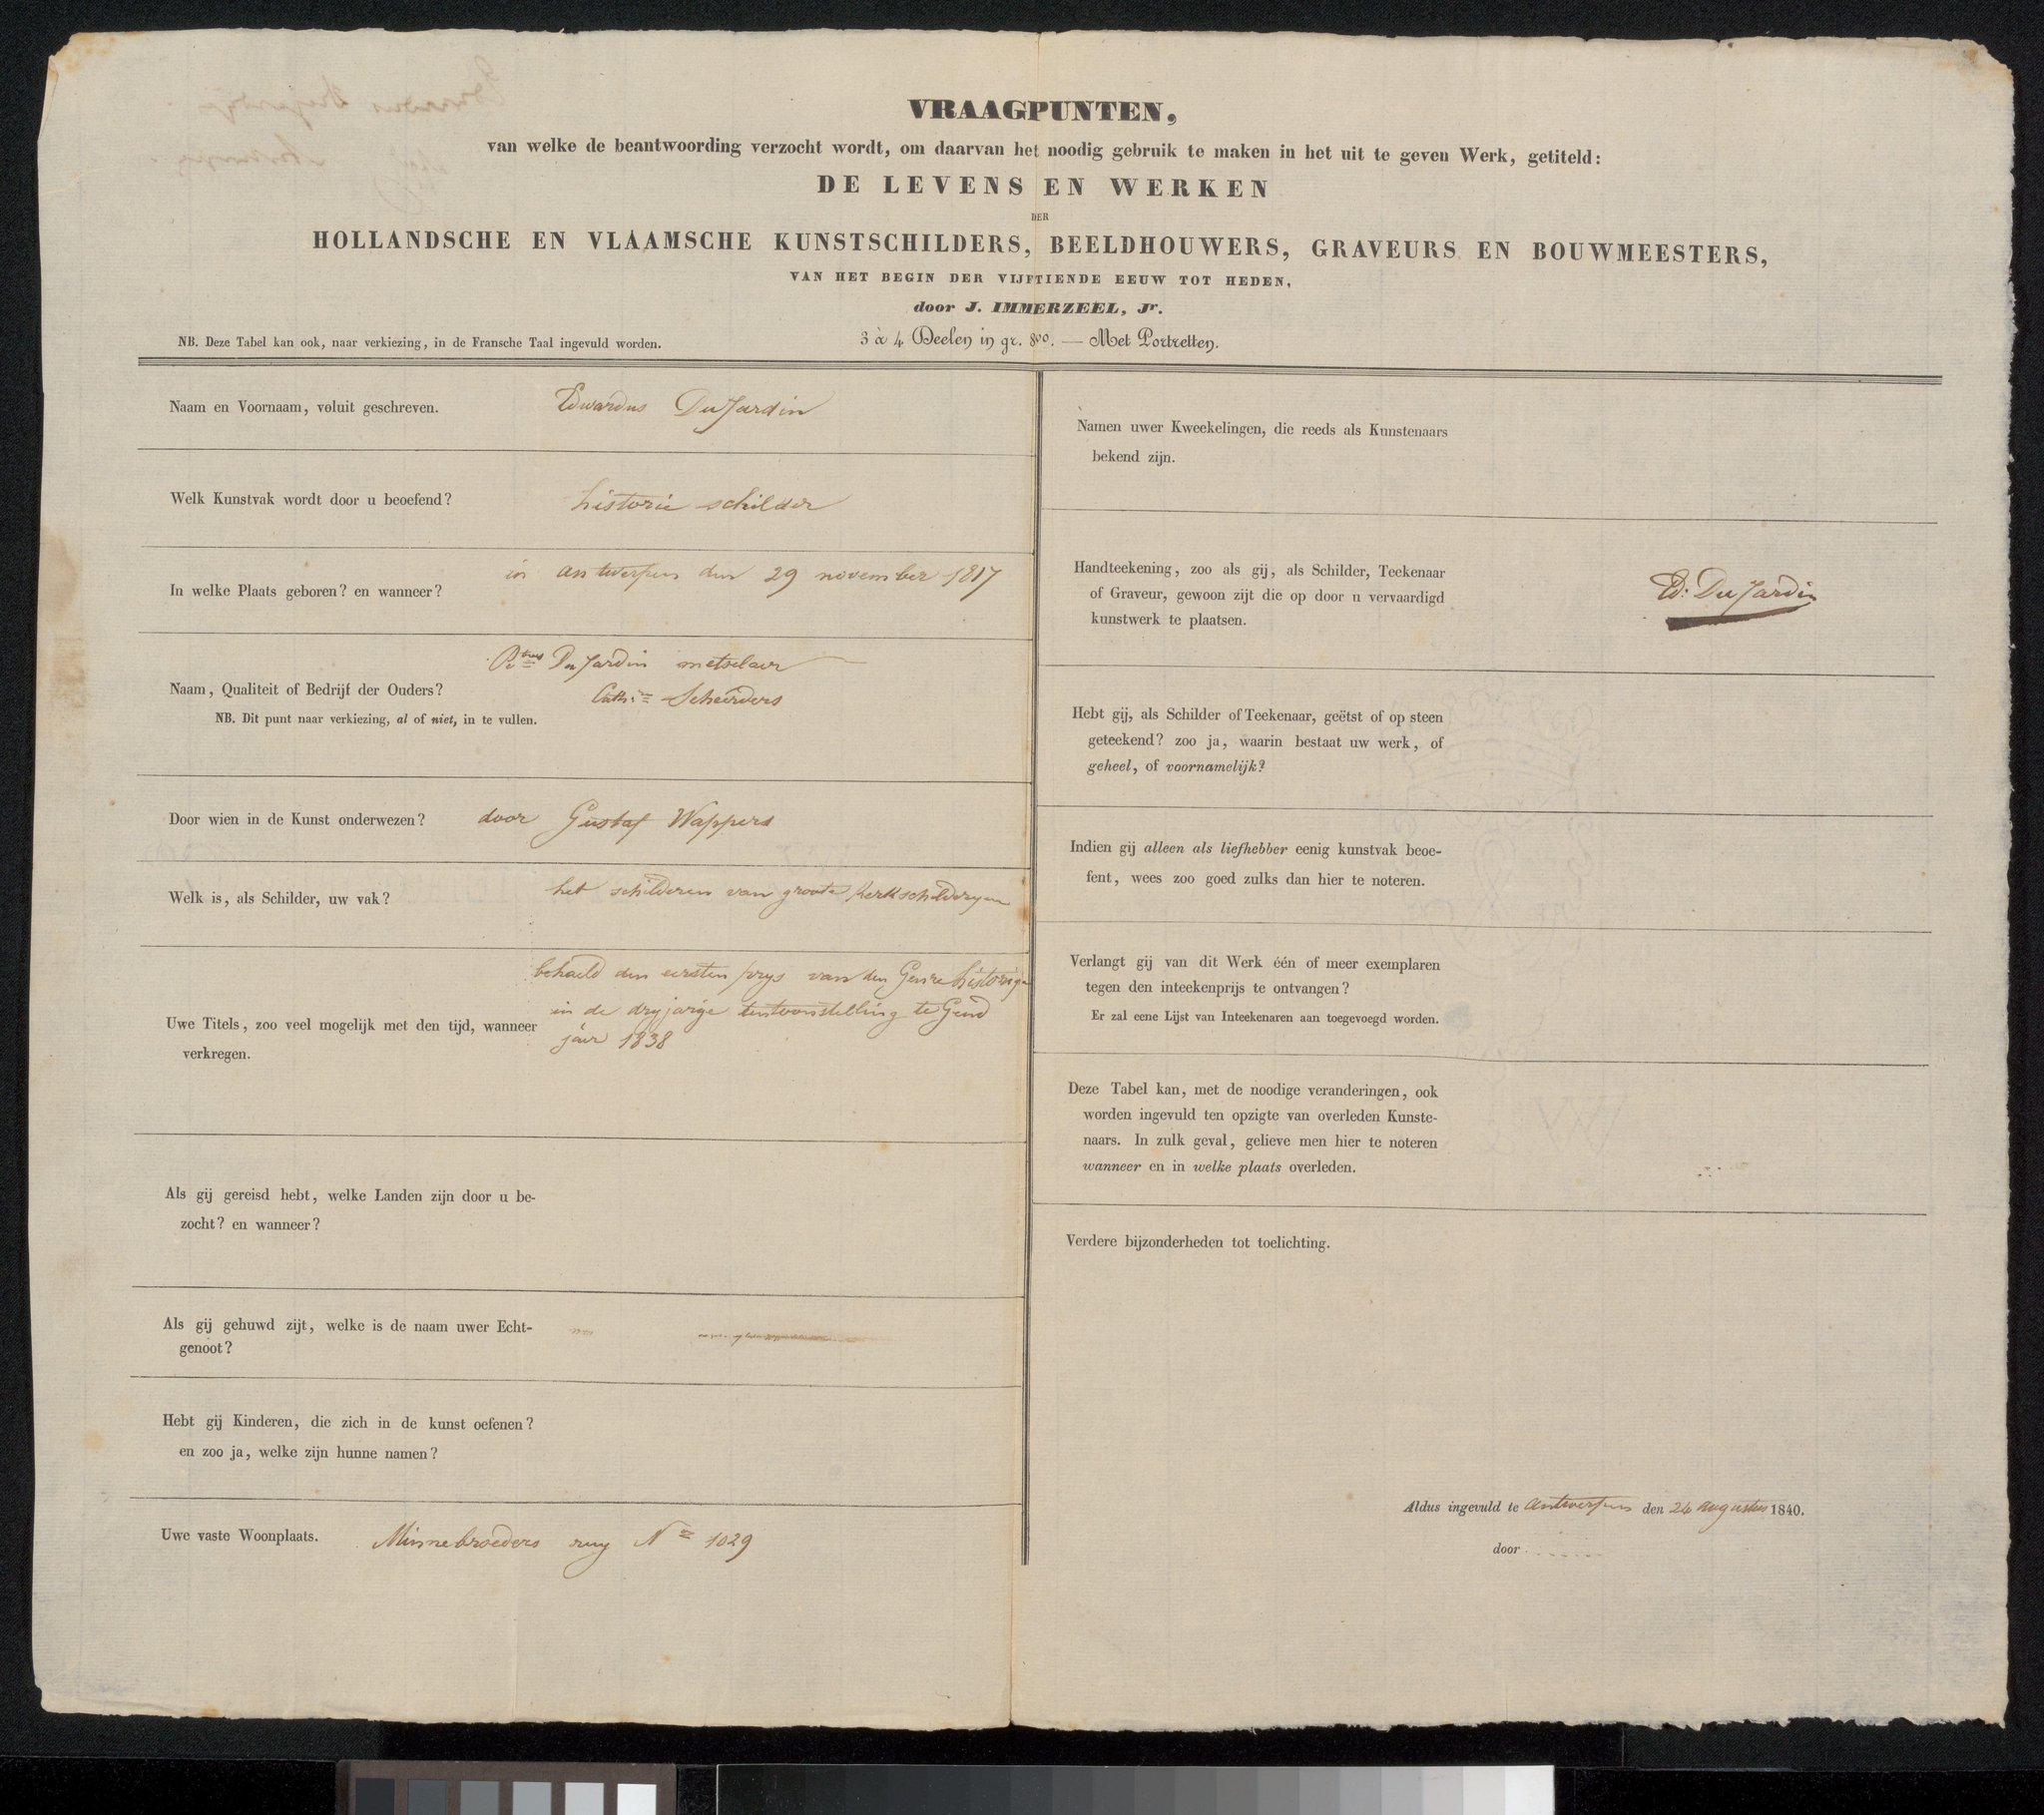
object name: manuscript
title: Enquêteformulier ingevuld door Edouard Dujardin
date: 1840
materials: ink, paper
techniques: pen, printing, writing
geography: antwerp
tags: print maker, draughtsman, edouard dujardin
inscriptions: inscription: ‘Vraagpunten,/ van welke de beantwoording verzocht wordt, om daarvan het noodig gebruik te maken in het uit te geven Werk, getiteld: De levens en werken/ der Hollandsche en Vlaamsche kunstschilders, beeldhouwers,/ graveurs en bouwmeesters, van het begin der vijftiende eeuw tot heden/ door J. Immerzeel, Jr.’, watermark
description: Opgenomen in: Immerzeel, J. Jr., De levens en werken der Hollandsche en Vlaamsche kunstschilders, beeldhouwers, graveurs en bouwmeesters, van het begin der vijftiende eeuw tot heden, Amsterdam: J.C. van Kesteren, 1842-1843.